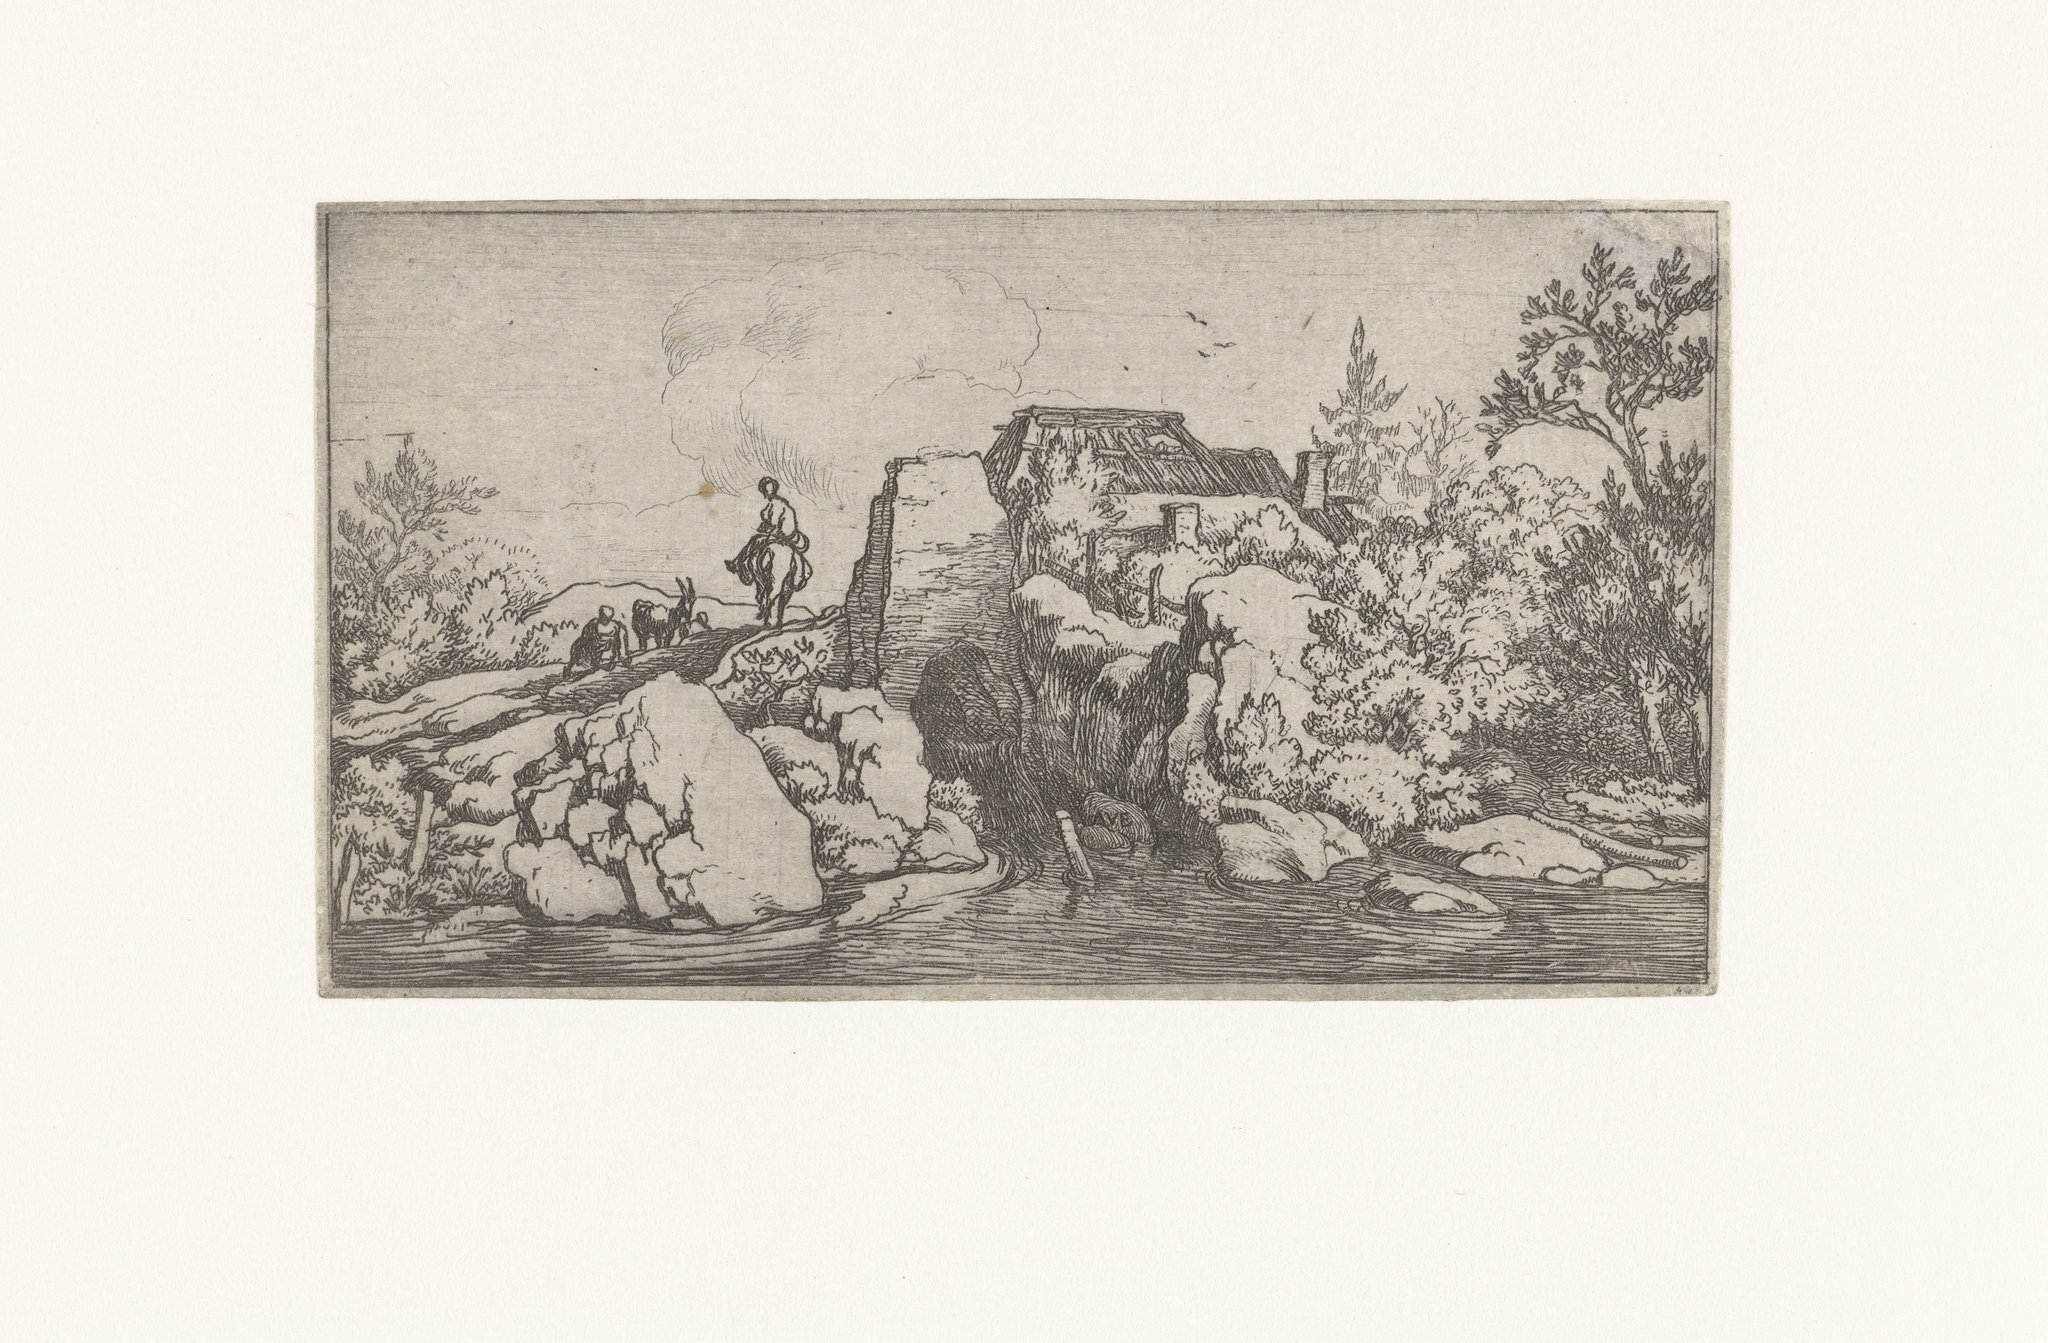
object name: print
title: De persoon te paard op den steenen brug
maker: allaert van everdingen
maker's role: draughtsman, painter, print maker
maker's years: 1621-1675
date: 1631-1675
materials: paper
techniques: etching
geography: netherlands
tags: landscape with bridge, viaduct or aqueduct - ii - ideal landscapes (+ city(-scape) with figures, staffage)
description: Landschap met waterpartij op de voorgrond. Op het pad over de rivier staat een bok en een persoon op een paard. Aan de overkant van de brug zijn enkele daken zichtbaar.